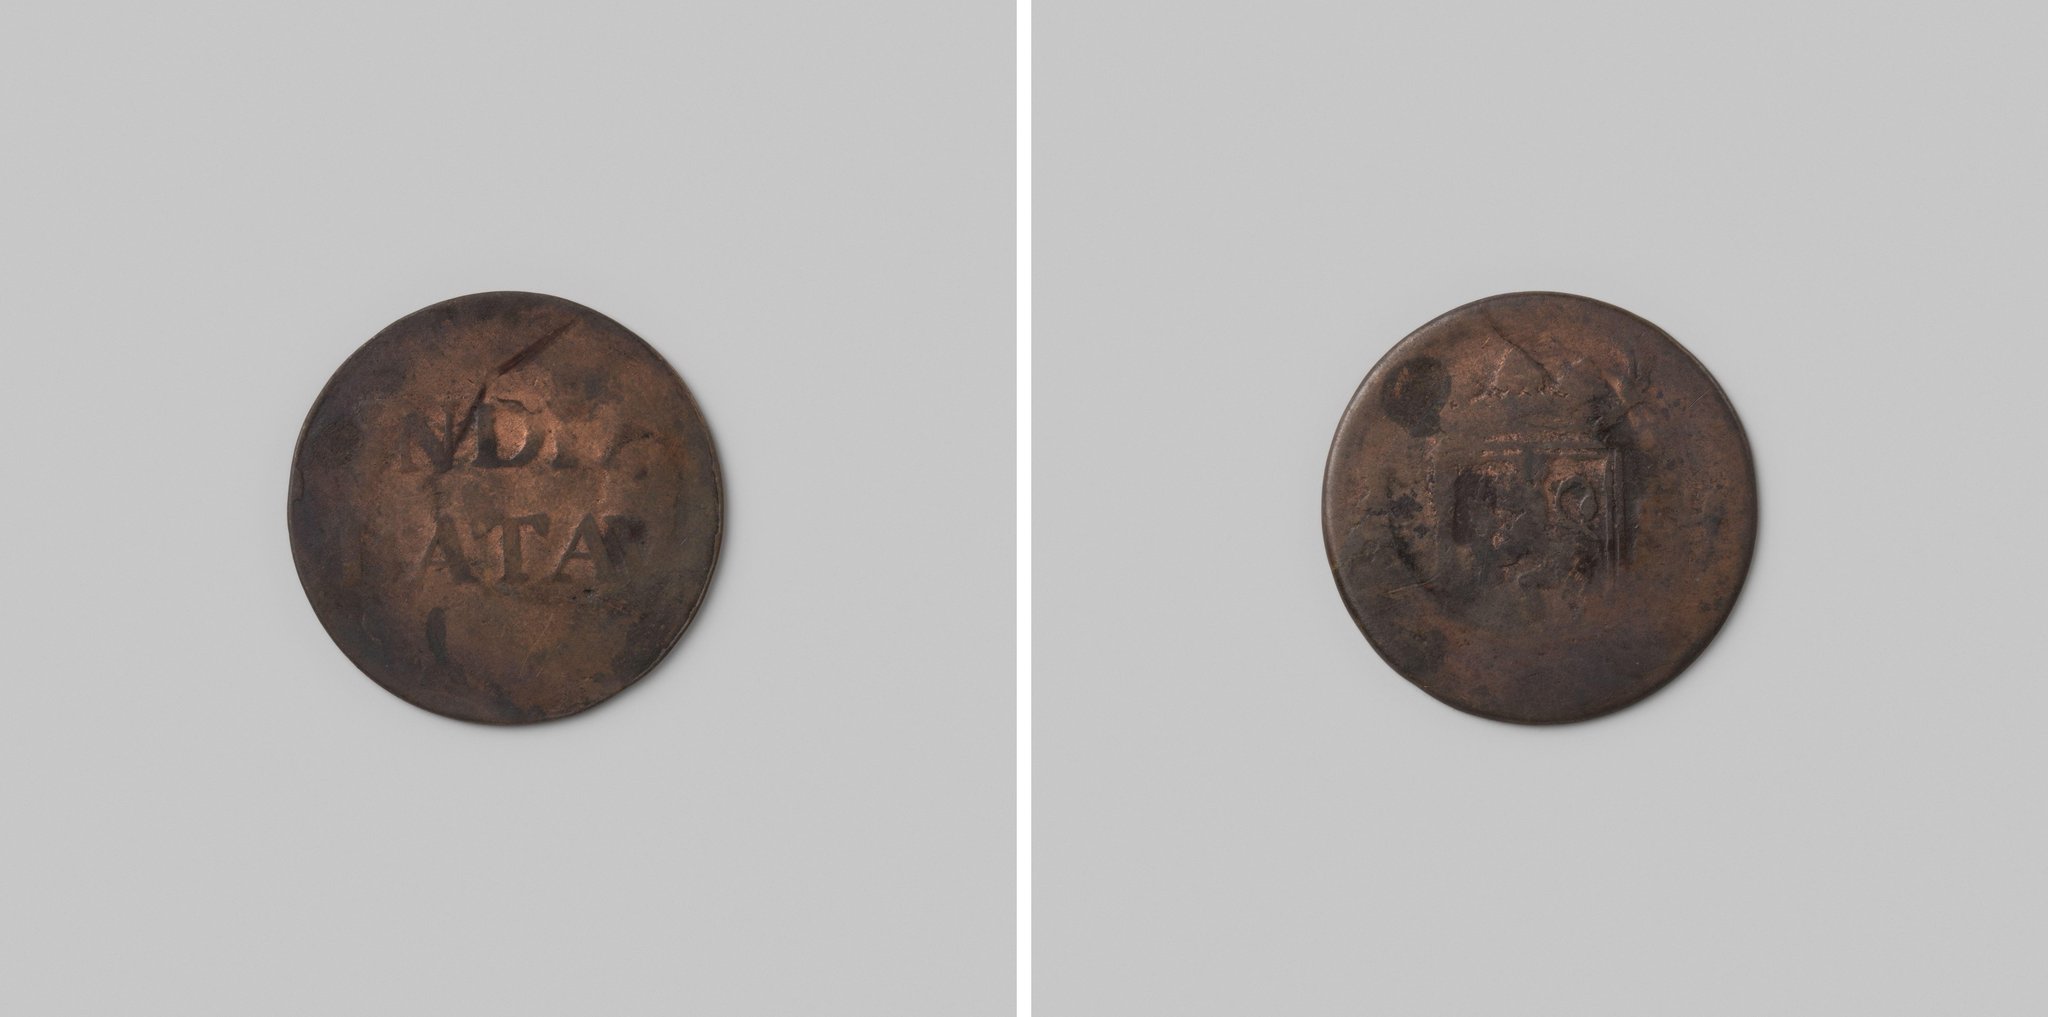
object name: coin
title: Koperen VOC-munt uit Nederlands-Indië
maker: Anonymous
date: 1700-1900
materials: copper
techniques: striking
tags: dutch east indies, the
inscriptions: inscription: ‘...ND... / ..ATA...’, inscription: ‘Jacques Schulman / Numismaat / Keizersgracht 448 / Amsterdam-C.’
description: Koperen VOC-muntje uit Nederlands-Indië. Voorzijde: opschrift. Keerzijde: wapen met leeuw erin. Het muntje zit in een vierkant envelopje met opschrift.